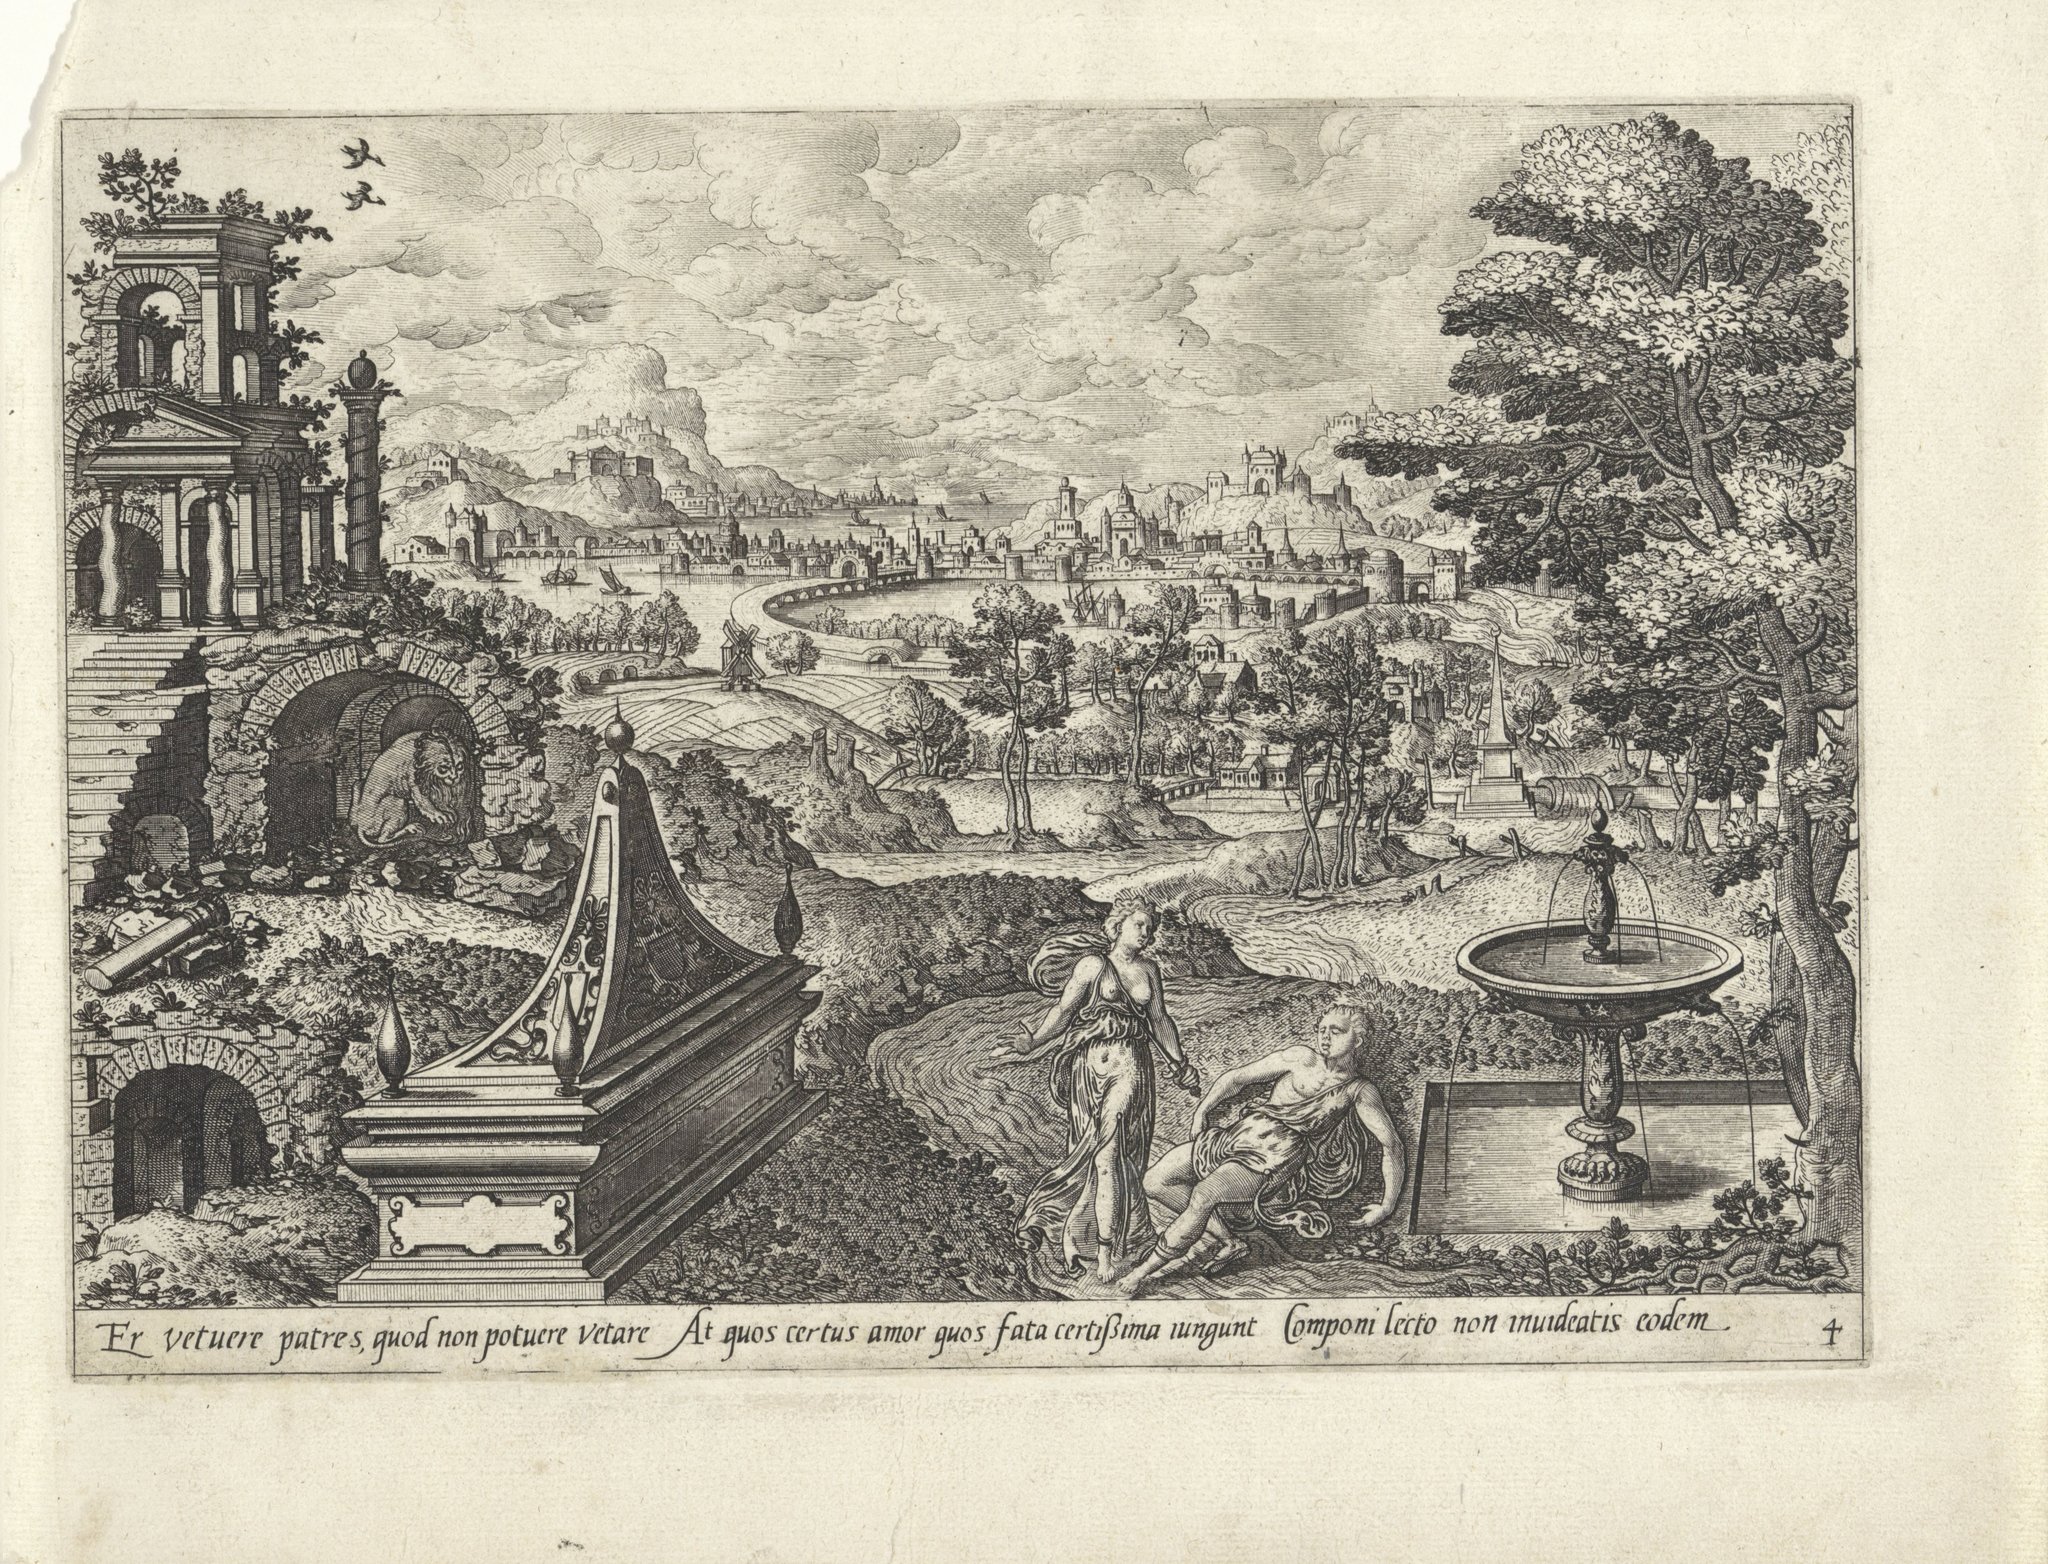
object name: print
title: Metamorfosen van Ovidius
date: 1601-1652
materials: paper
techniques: engraving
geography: antwerp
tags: thisbe discovers the dying pyramus (the scene may be represented near a fountain)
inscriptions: collector's mark: Lugt 2228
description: Landschap met de dode Pyramus bij een fontein. Hij heeft zichzelf neergestoken, omdat hij dacht dat Thisbe door een leeuw was gedood. Thisbe ontdekt haar stervende geliefde, waarop zij zelfmoord pleegt met het zwaard van Pyramus. Links op de achtergrond zit de leeuw onder een stenen boog. Onder de voorstelling een verklarende tekst. De eerste regel uit de Metamorfosen van Ovidius, boek 4, versregel 61.